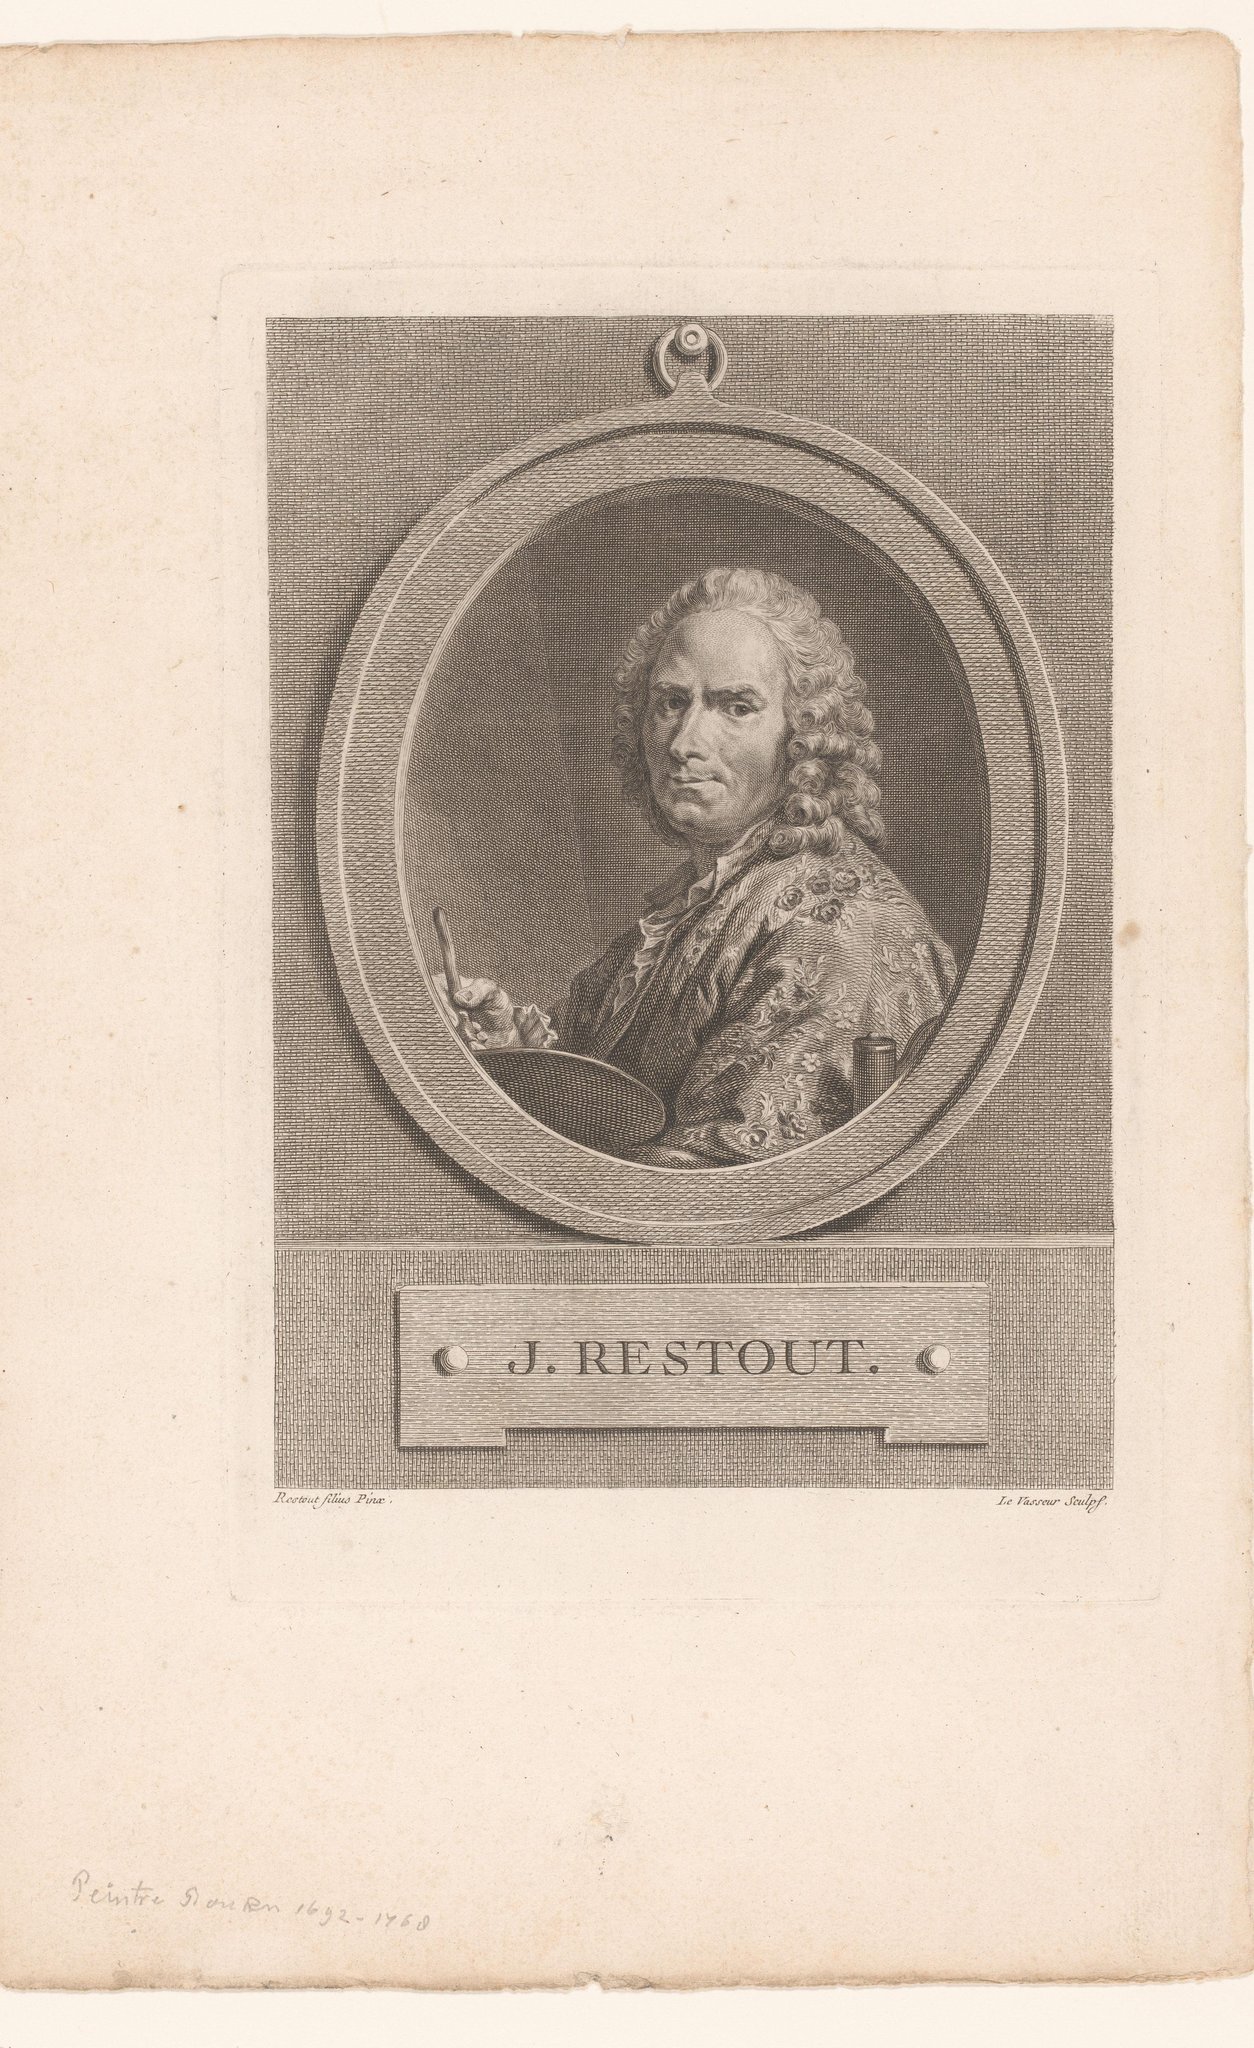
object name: print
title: Portret van Jean (I) Restout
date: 1744-1816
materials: paper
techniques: engraving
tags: jean restout (i), ornament ~ medallion, historical persons, portrait, self-portrait of painter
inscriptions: collector's mark: Lugt 2228